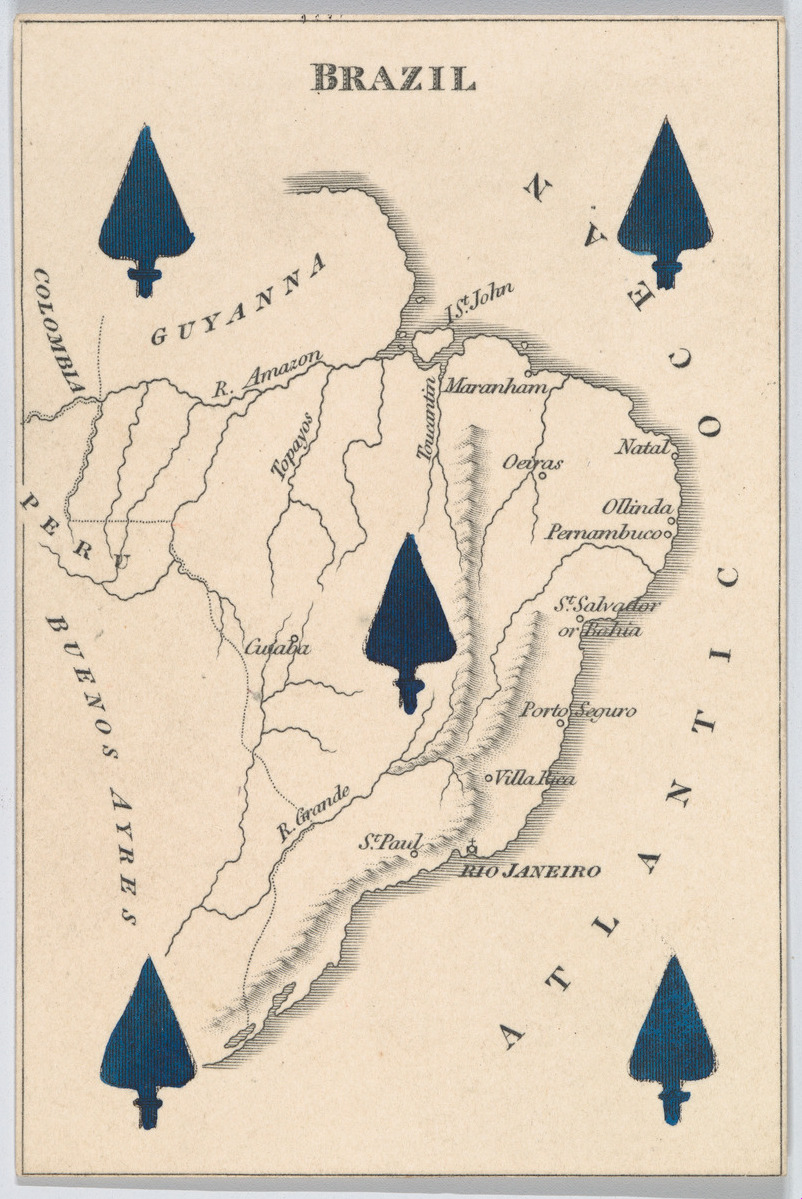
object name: print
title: Brazil, from "Court Game of Geography"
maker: william and henry rock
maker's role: publisher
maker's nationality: british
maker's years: 1821-1884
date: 1838-1855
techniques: engraving, hand coloring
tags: playing cards,maps